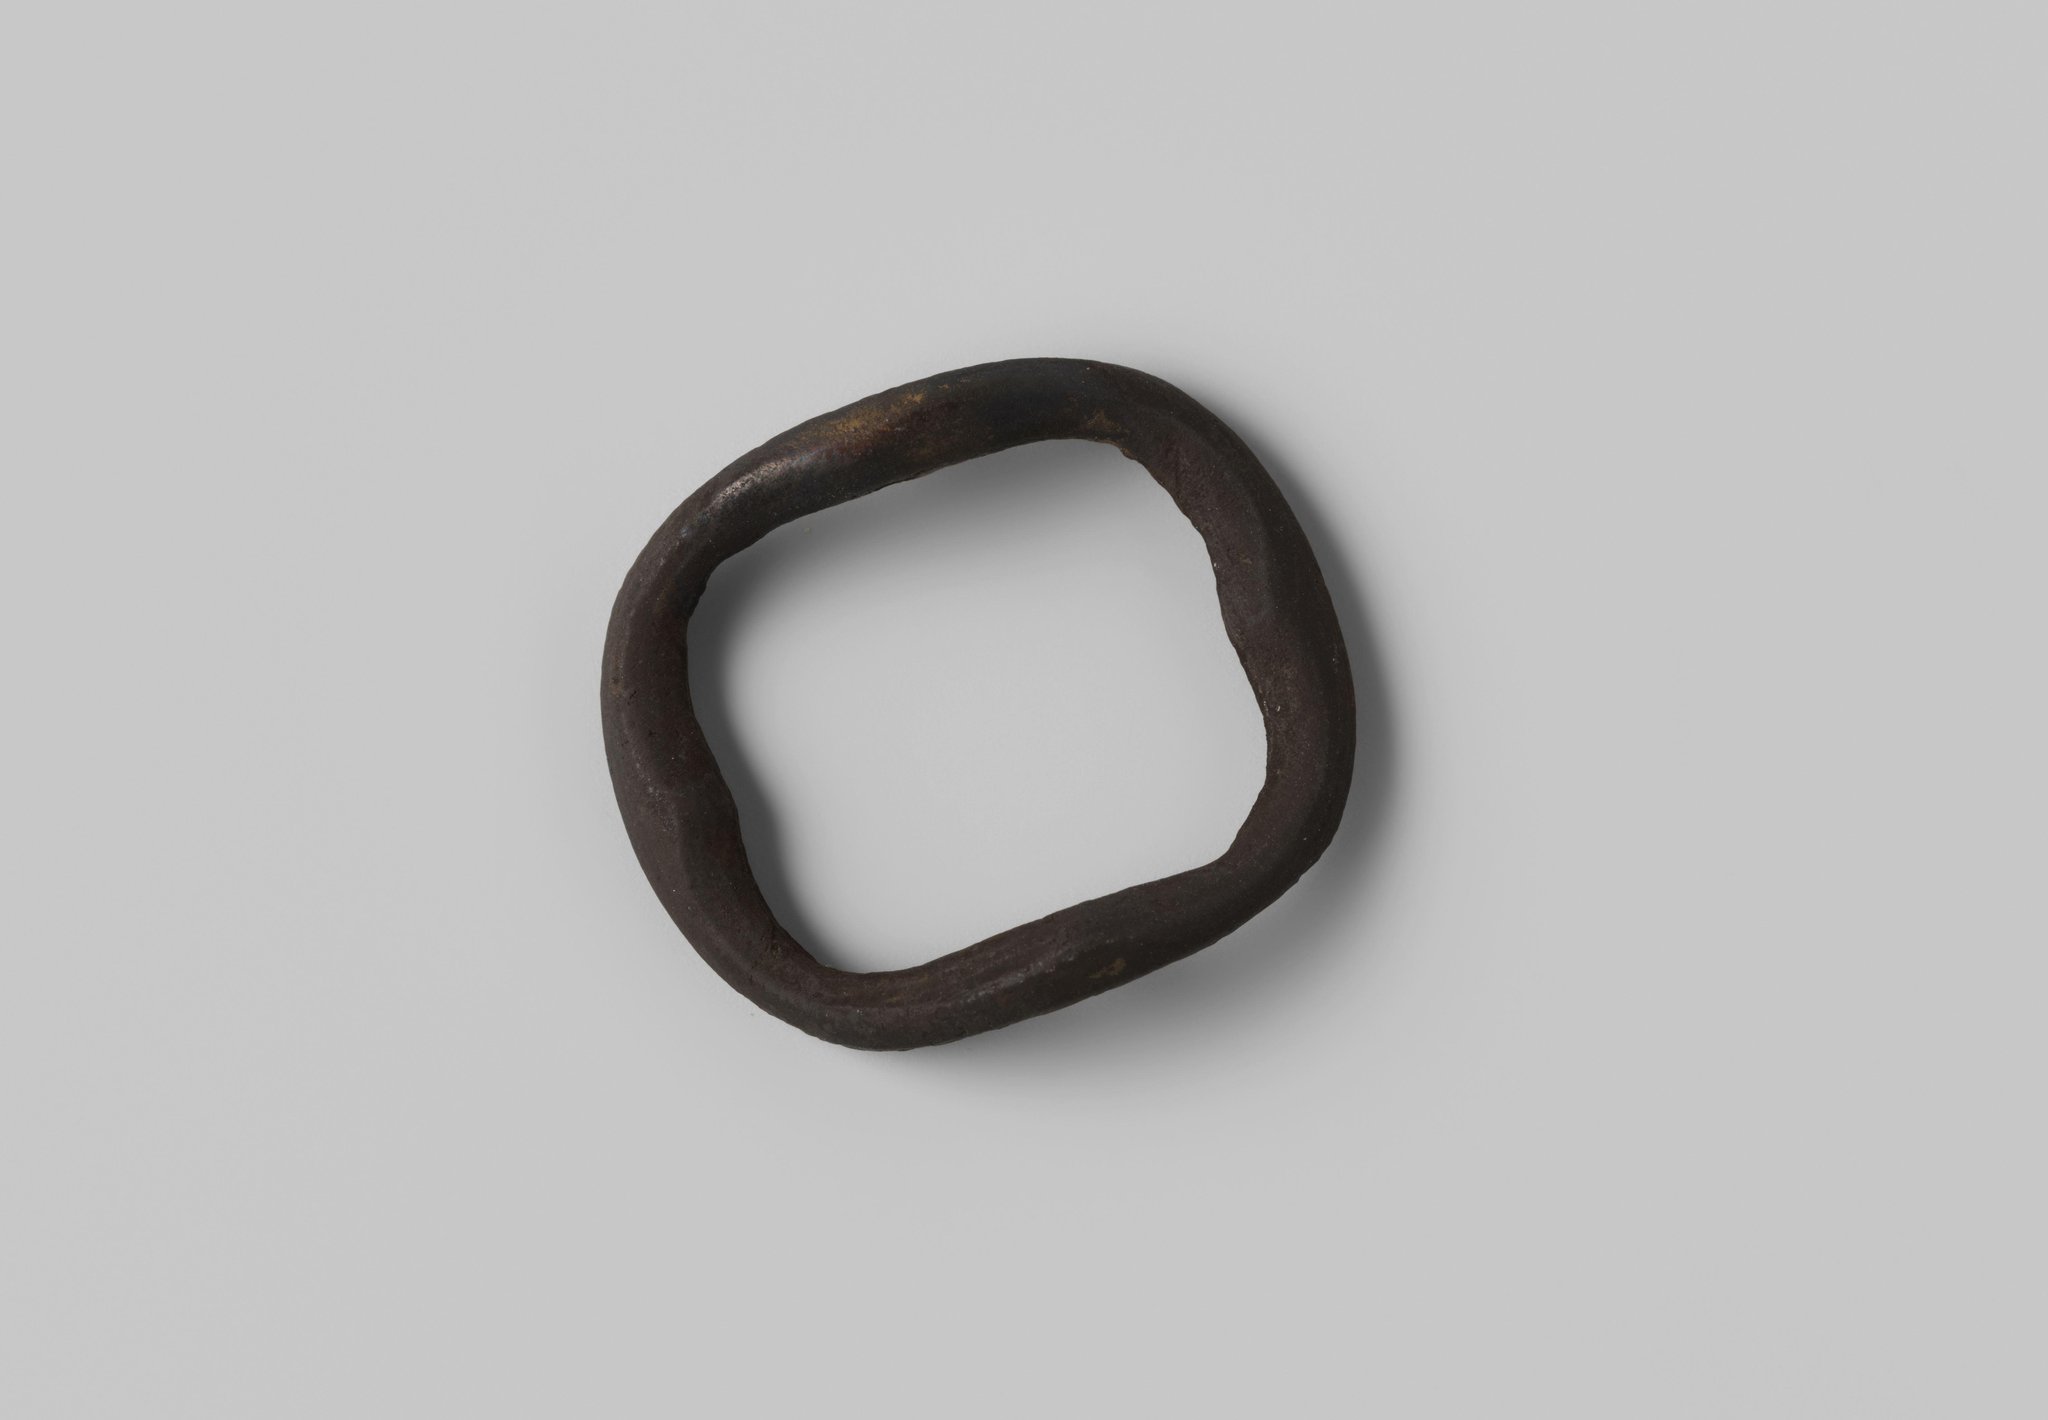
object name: knee buckle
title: Kniegesp uit het wrak van de Oost-Indiëvaarder Hollandia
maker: Anonymous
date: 1700-1743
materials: copper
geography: netherlands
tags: verenigde oostindische compagnie, hollandia (schip), annet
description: Buckle, chape buckle, knee buckle; ring, id. NG 1980-27H3336.